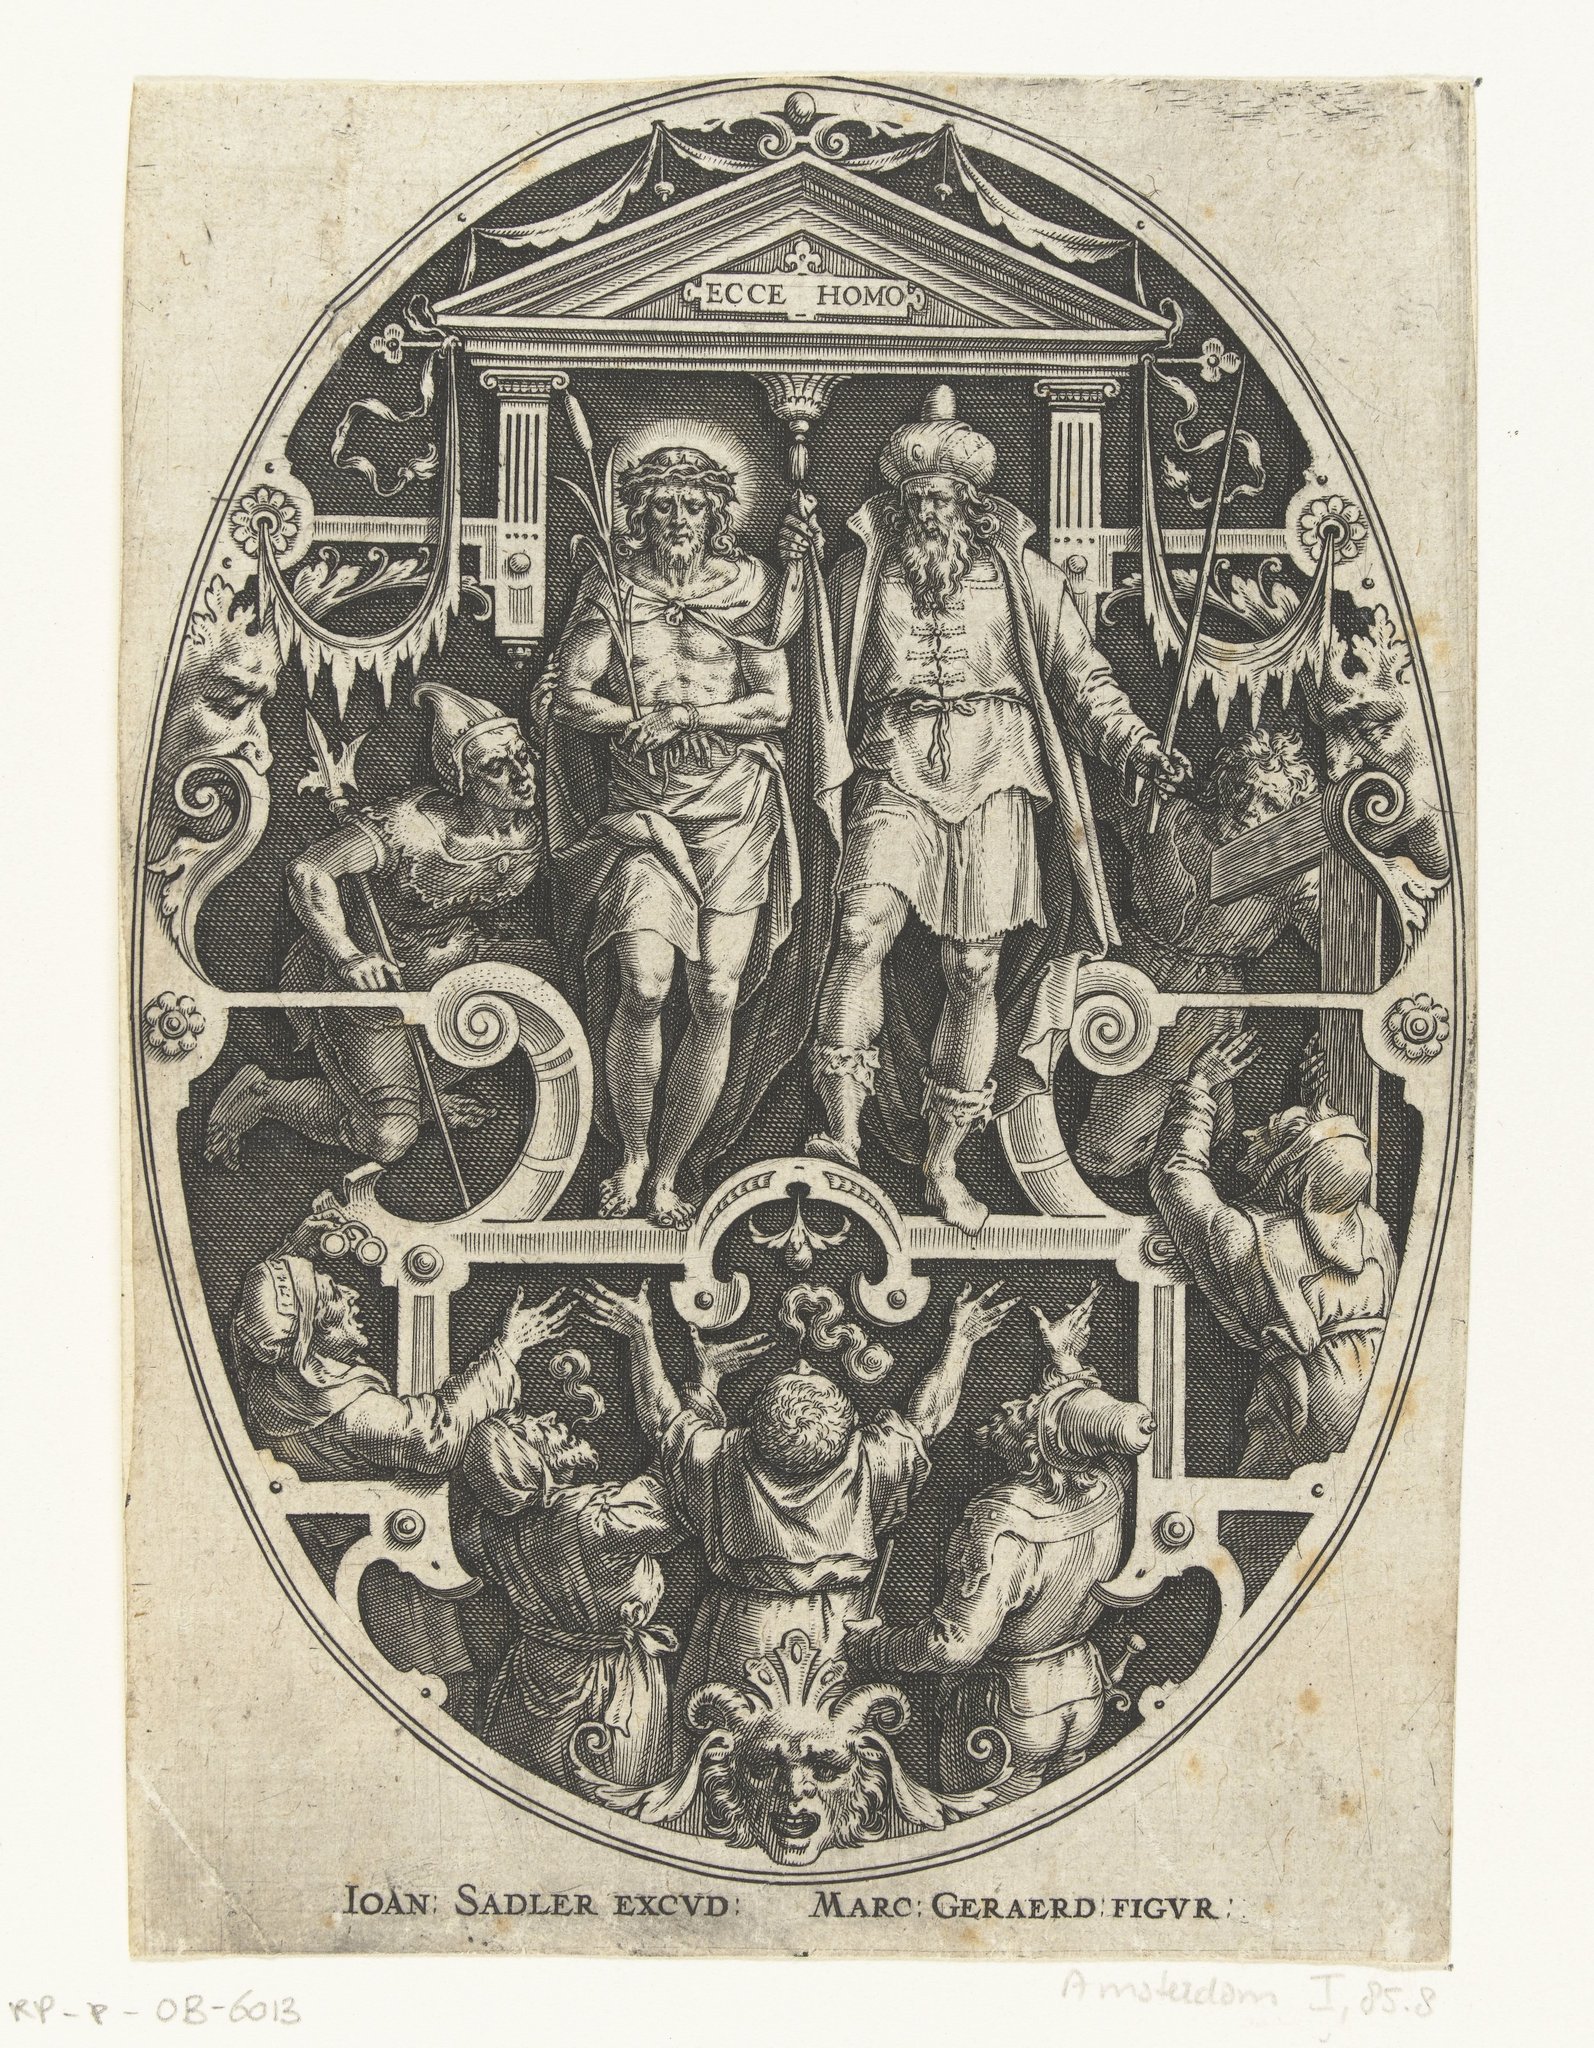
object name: ornament print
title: Passio verbigenae quae redeptio Christ (...)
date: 1560-1600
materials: paper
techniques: engraving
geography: netherlands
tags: pilate showing christ to the people, 'ostentatio christi', 'ecce homo' (john 19:4-6)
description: Uit serie van 14 ovalen met grotesken waarin scènes uit de passie zijn afgebeeld. Gearceerde achtergrond.